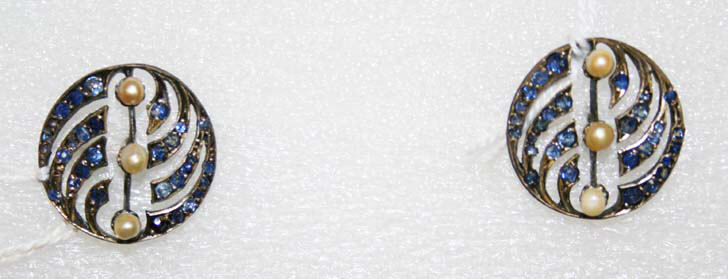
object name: button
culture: french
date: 1780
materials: metal, pearl, gemstone